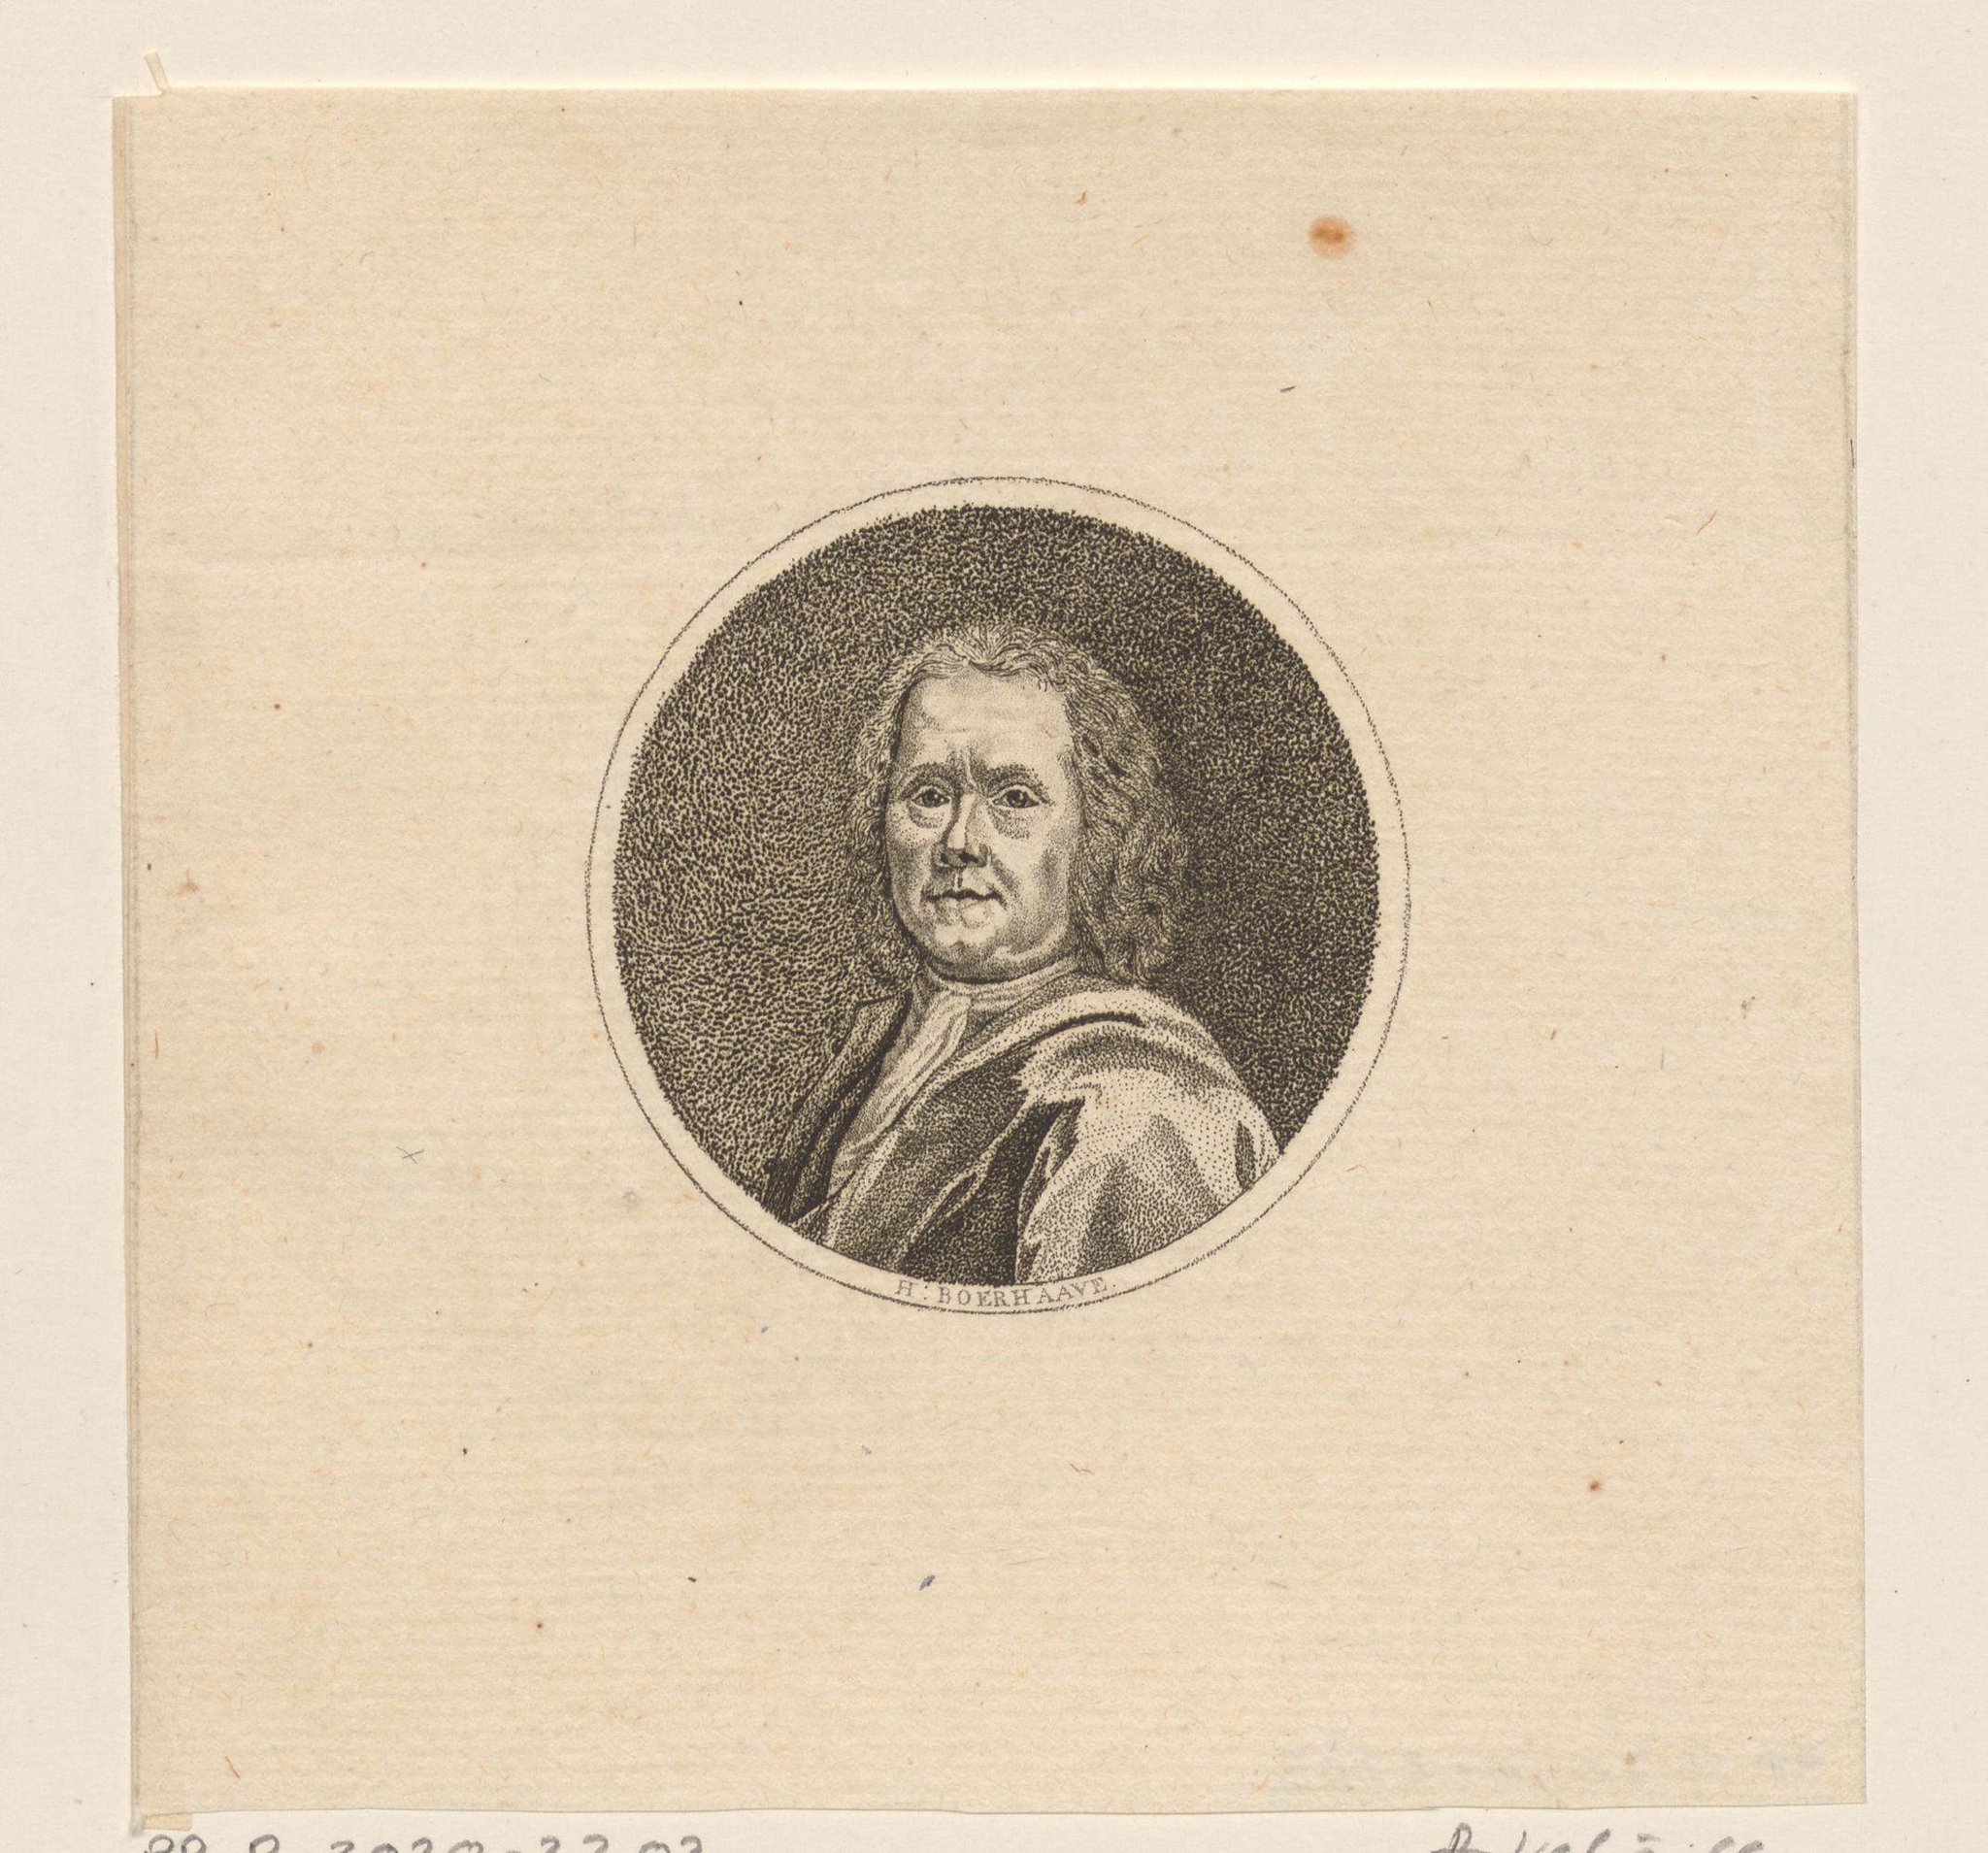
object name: print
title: Portret van Hermanus Boerhaave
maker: Anonymous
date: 1750-1799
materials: paper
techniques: etching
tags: leiden, hermanus boerhaave, historical persons, physician, doctor